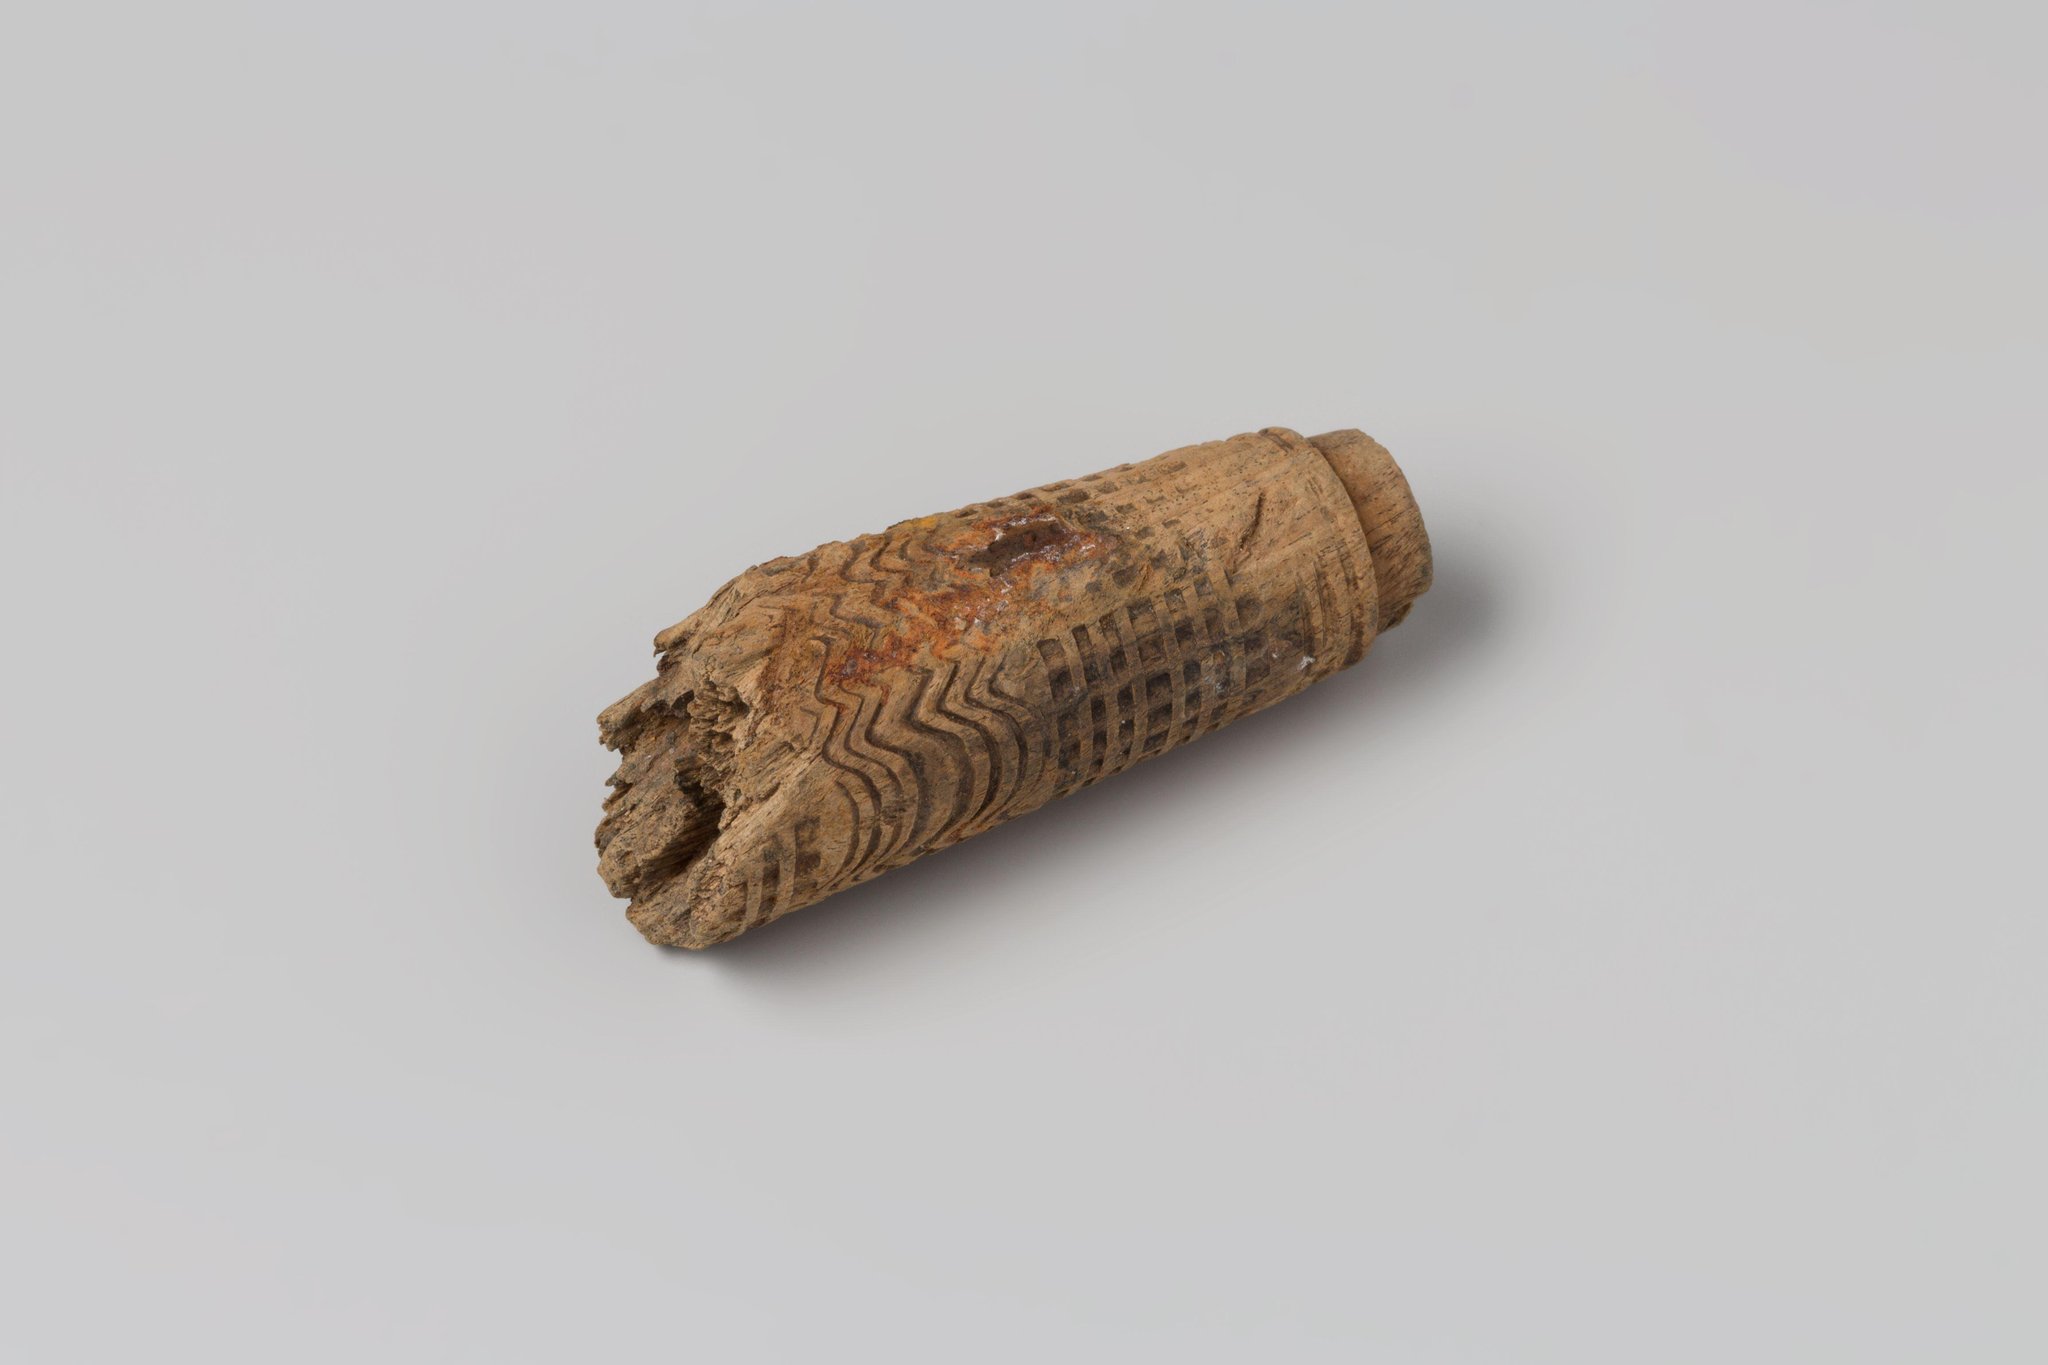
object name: knife handle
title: Fragment messenheft uit het wrak van de Oost-Indiëvaarder Hollandia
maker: Anonymous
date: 1700-1743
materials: wood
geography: netherlands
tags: verenigde oostindische compagnie, hollandia (schip), annet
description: Knife, handle, cylindrical: tapering; fragm, id. NG 1979-403H.